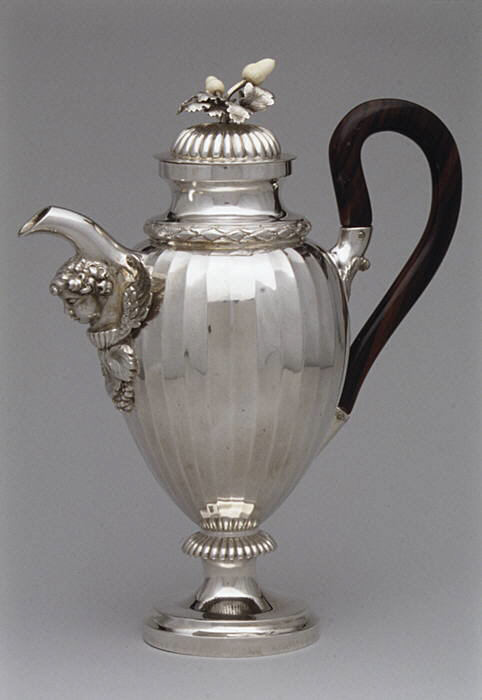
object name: hot milk pot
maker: alois simpert eschenlohr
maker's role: maker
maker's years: 1785-1837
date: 1823-1824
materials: wood, ivory, silver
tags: faces,flowers